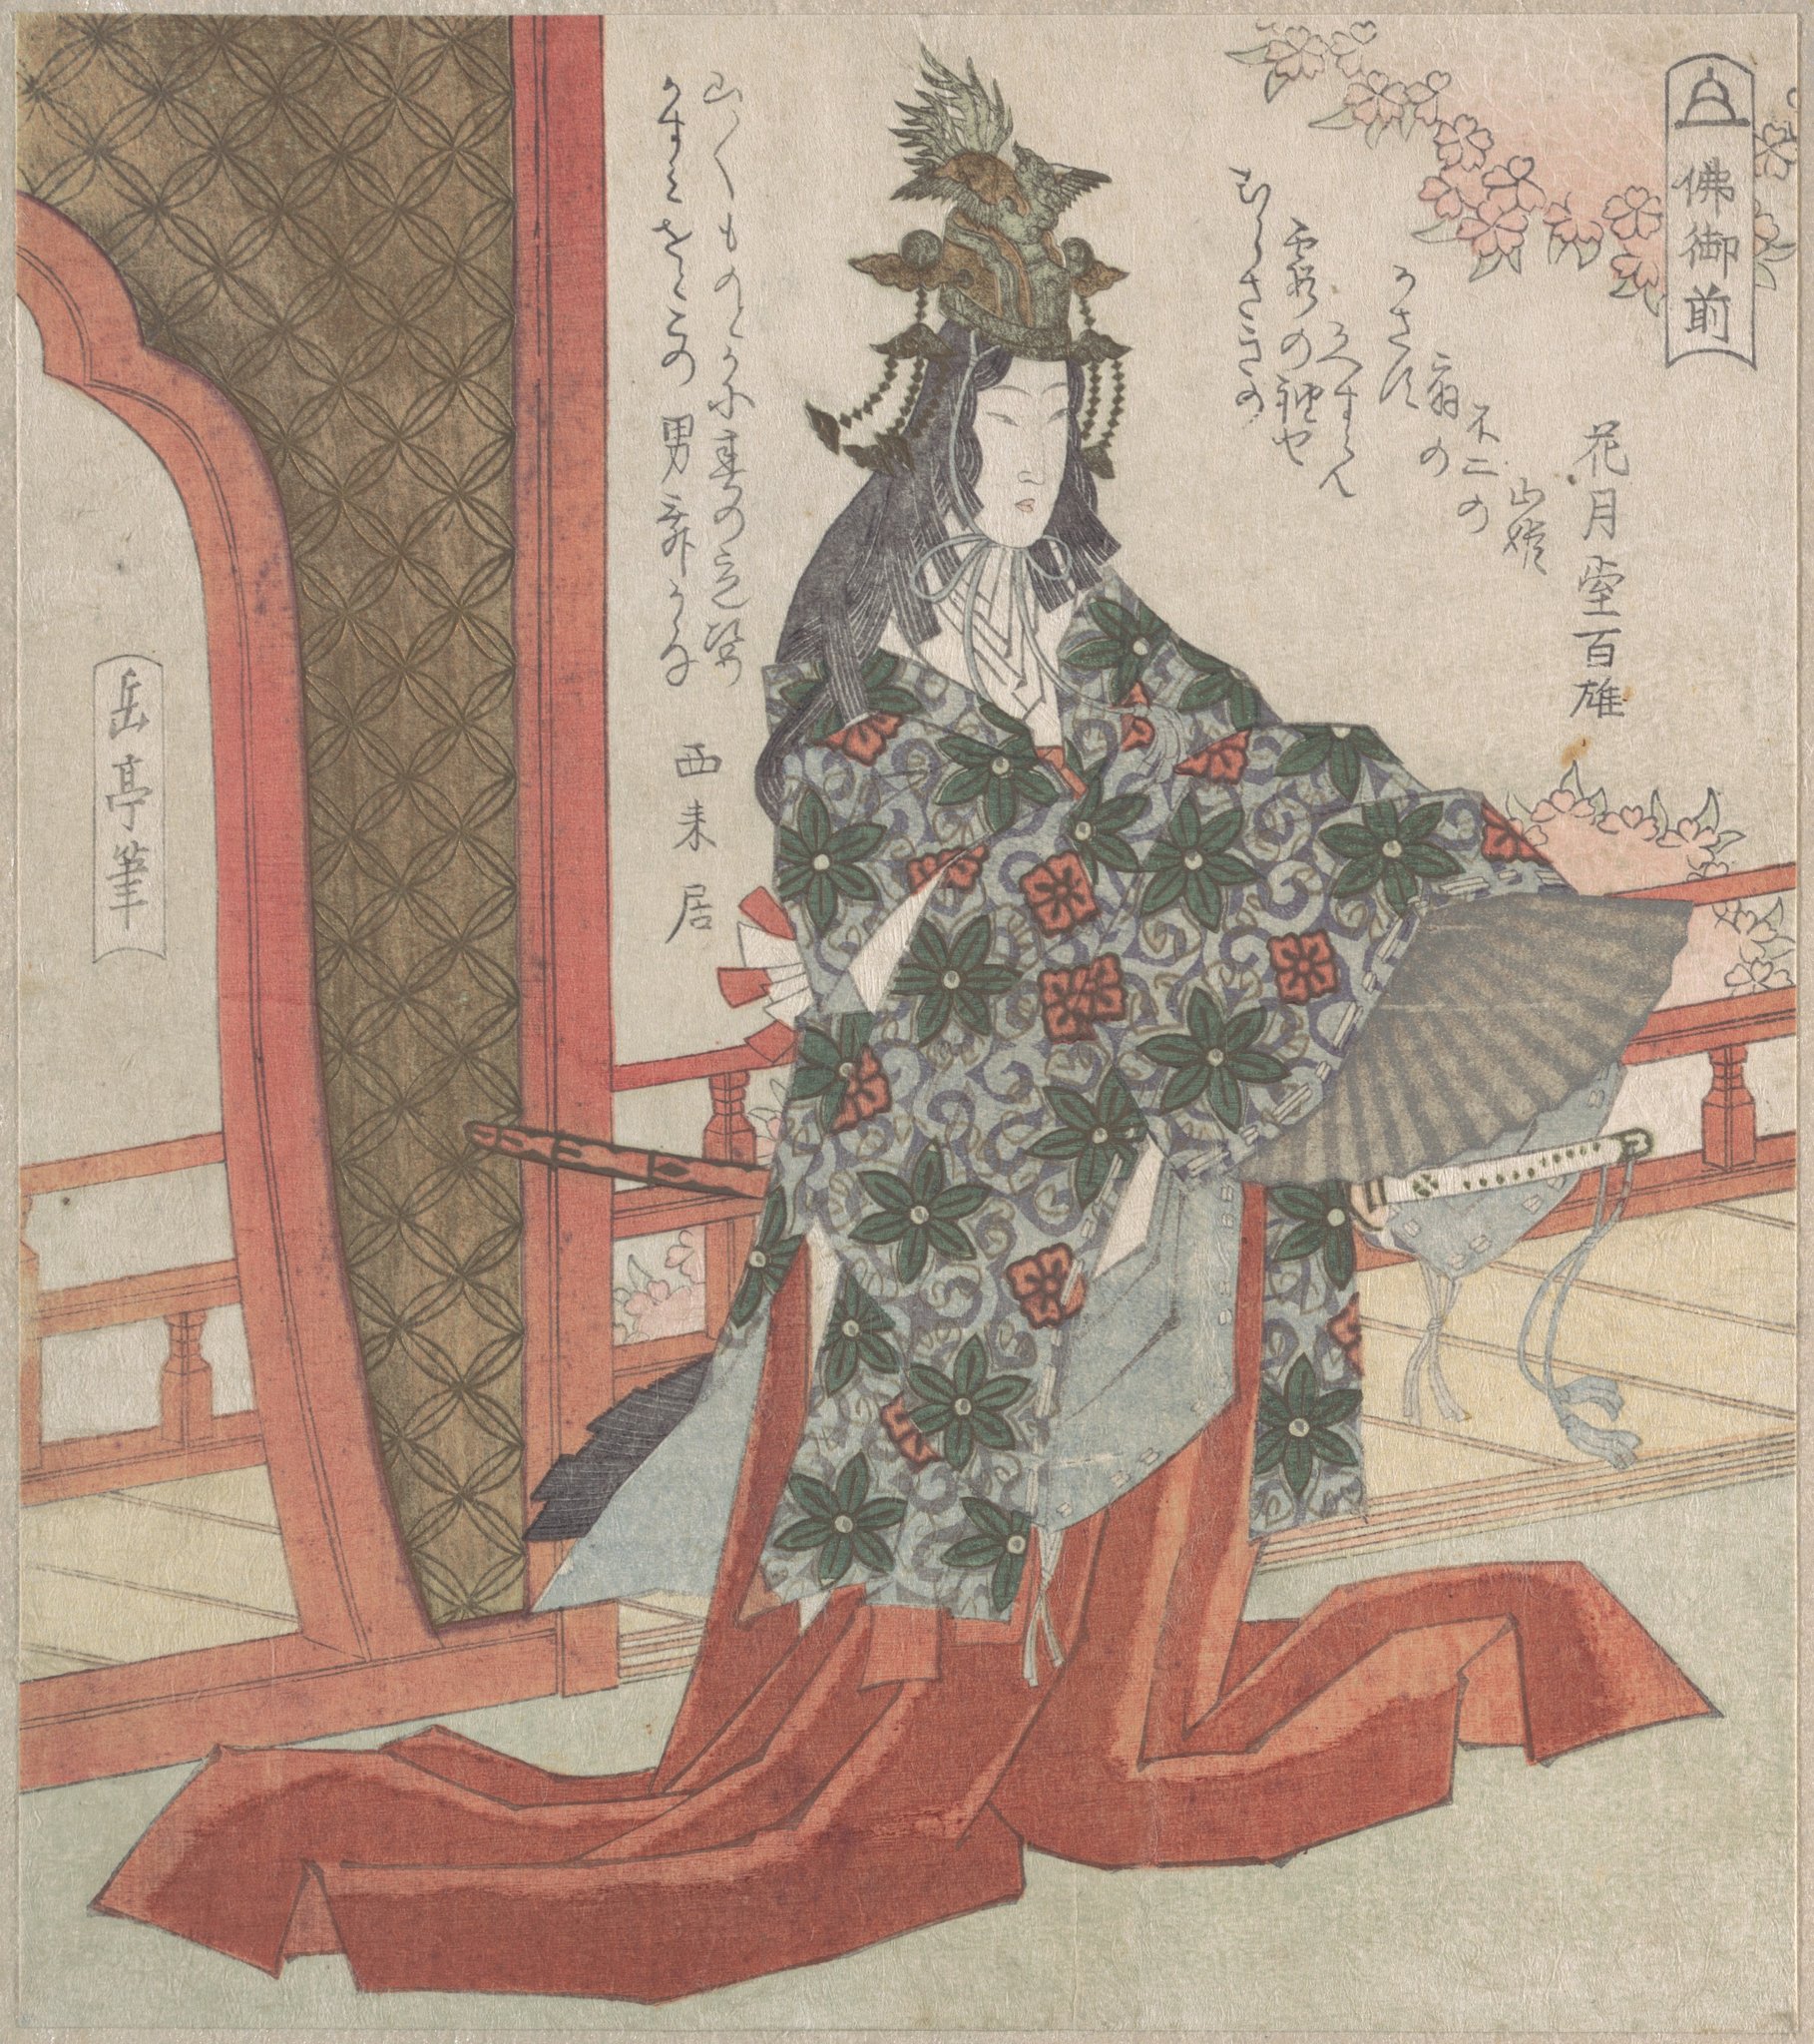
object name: print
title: Lady Hotoke Dancing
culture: japanese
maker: yashima gakutei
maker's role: artist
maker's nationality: japanese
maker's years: 1786-1868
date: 1801-1900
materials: ink, paper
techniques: surimono, woodblock print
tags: fans,women